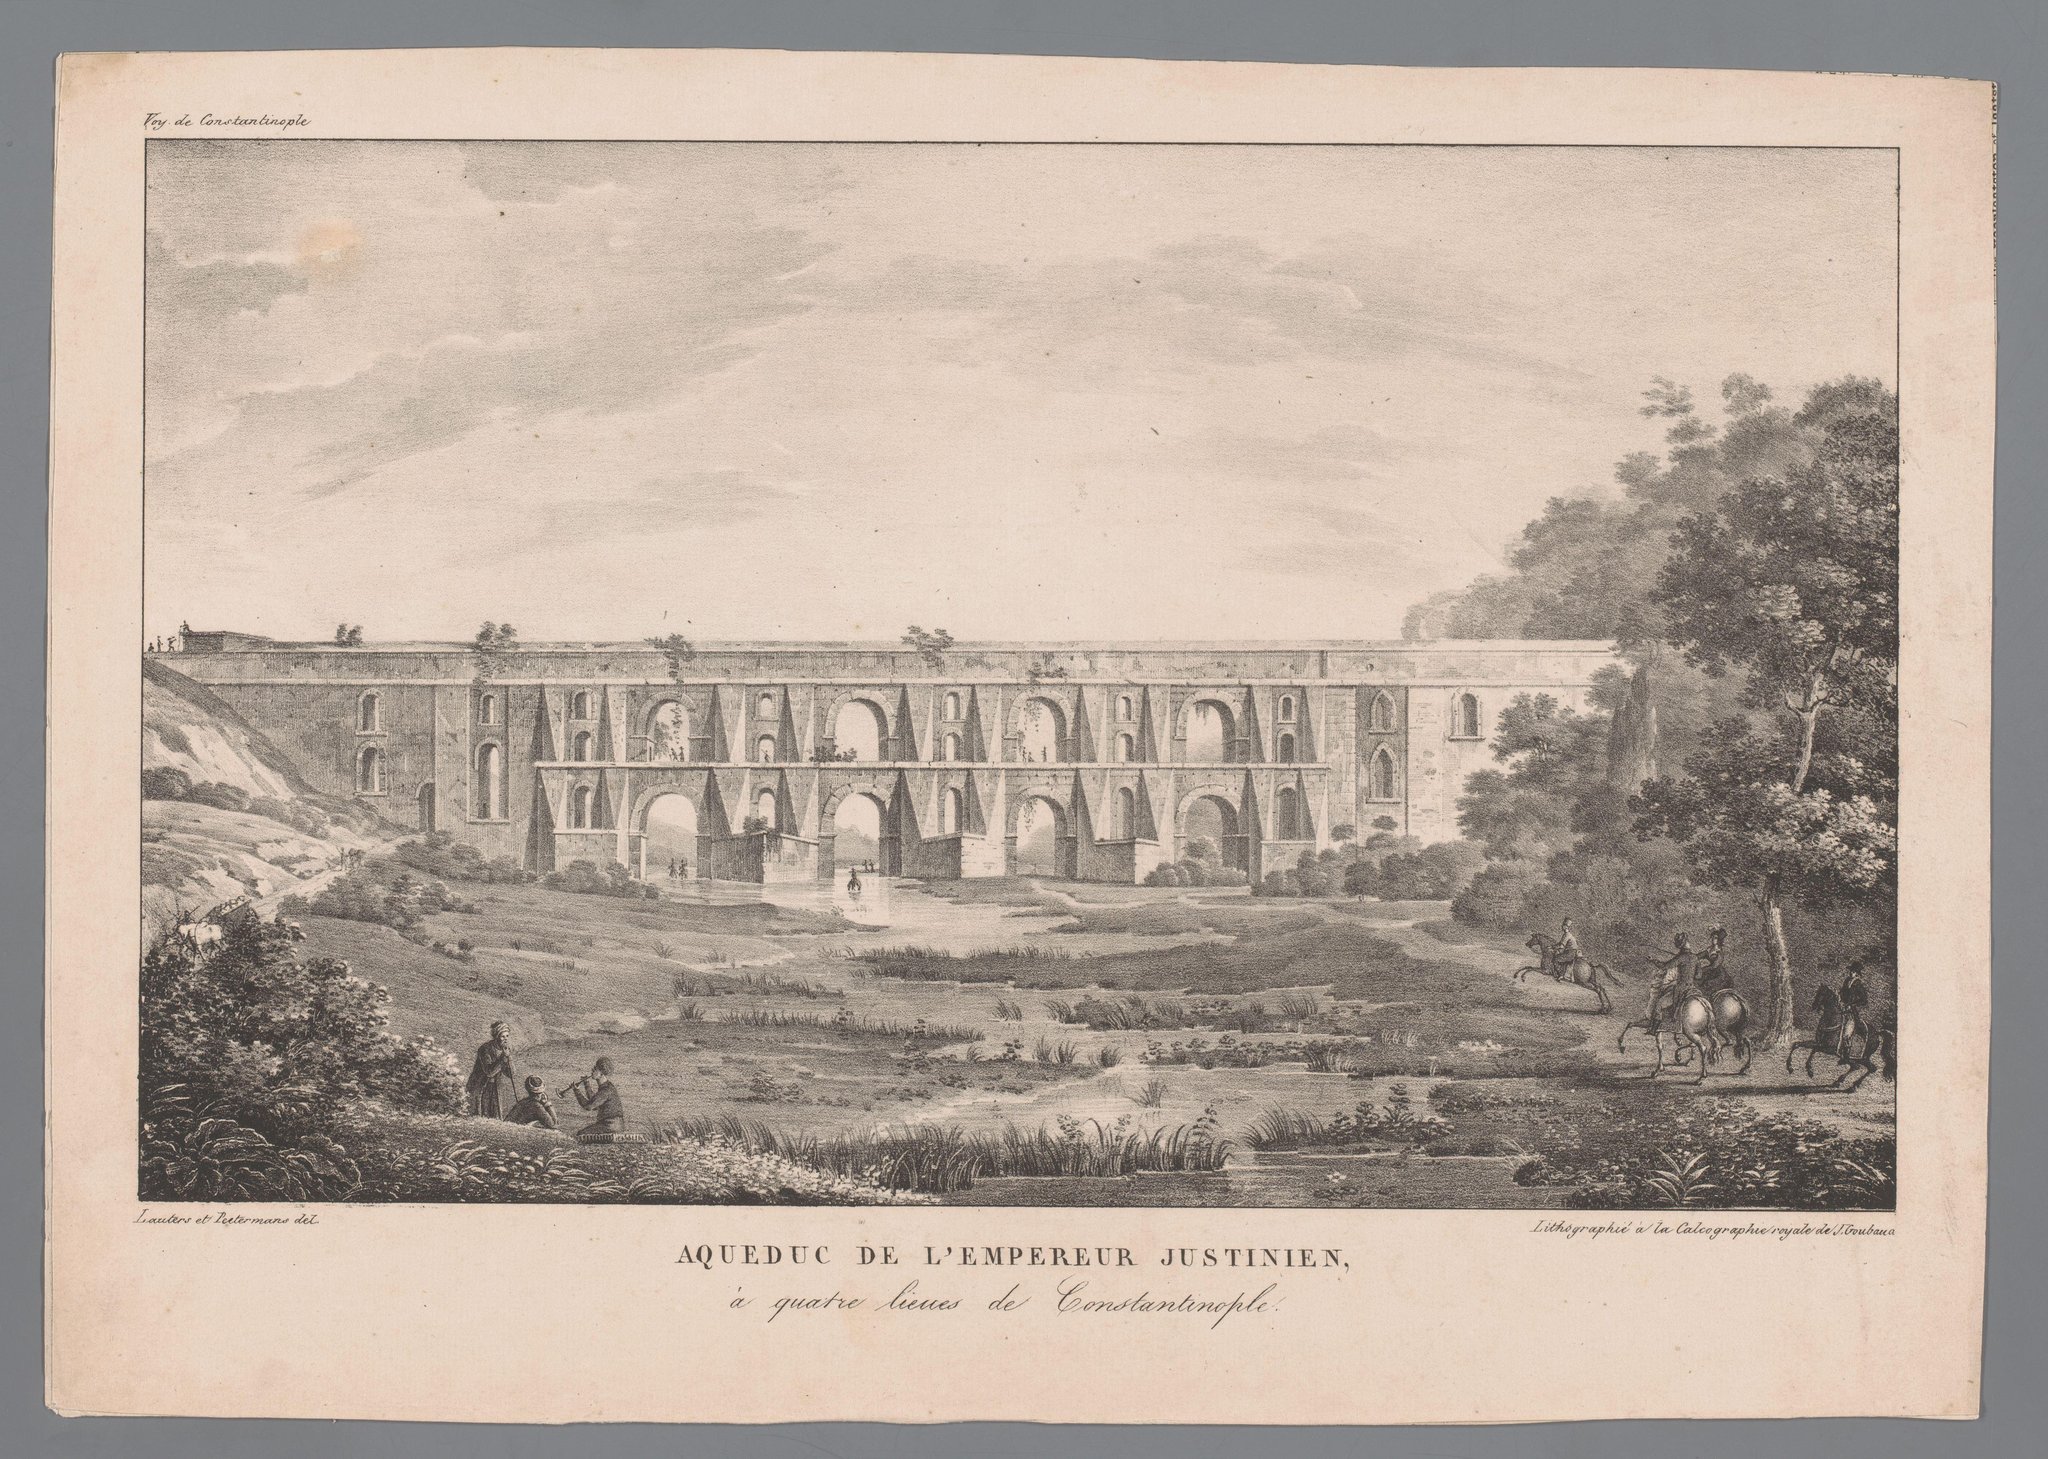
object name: print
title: Voy. de Constantinople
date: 1822-1828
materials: paper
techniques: letterpress printing, lithograph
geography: brussels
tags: landscape with bridge, viaduct or aqueduct, aqueduct (~ water supply)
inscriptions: collector's mark: Lugt 2228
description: Prent verschenen in: Barbié du Bocage, Jean Denis. Voyage pittoresque de Constantinople et des rives du Bosphore. Brussel: Innocent Louis Goubaud, 1822-1828. Deze publicatie bevat 48 litho's, die in afleveringen verschenen als illustratie bij de tekst.